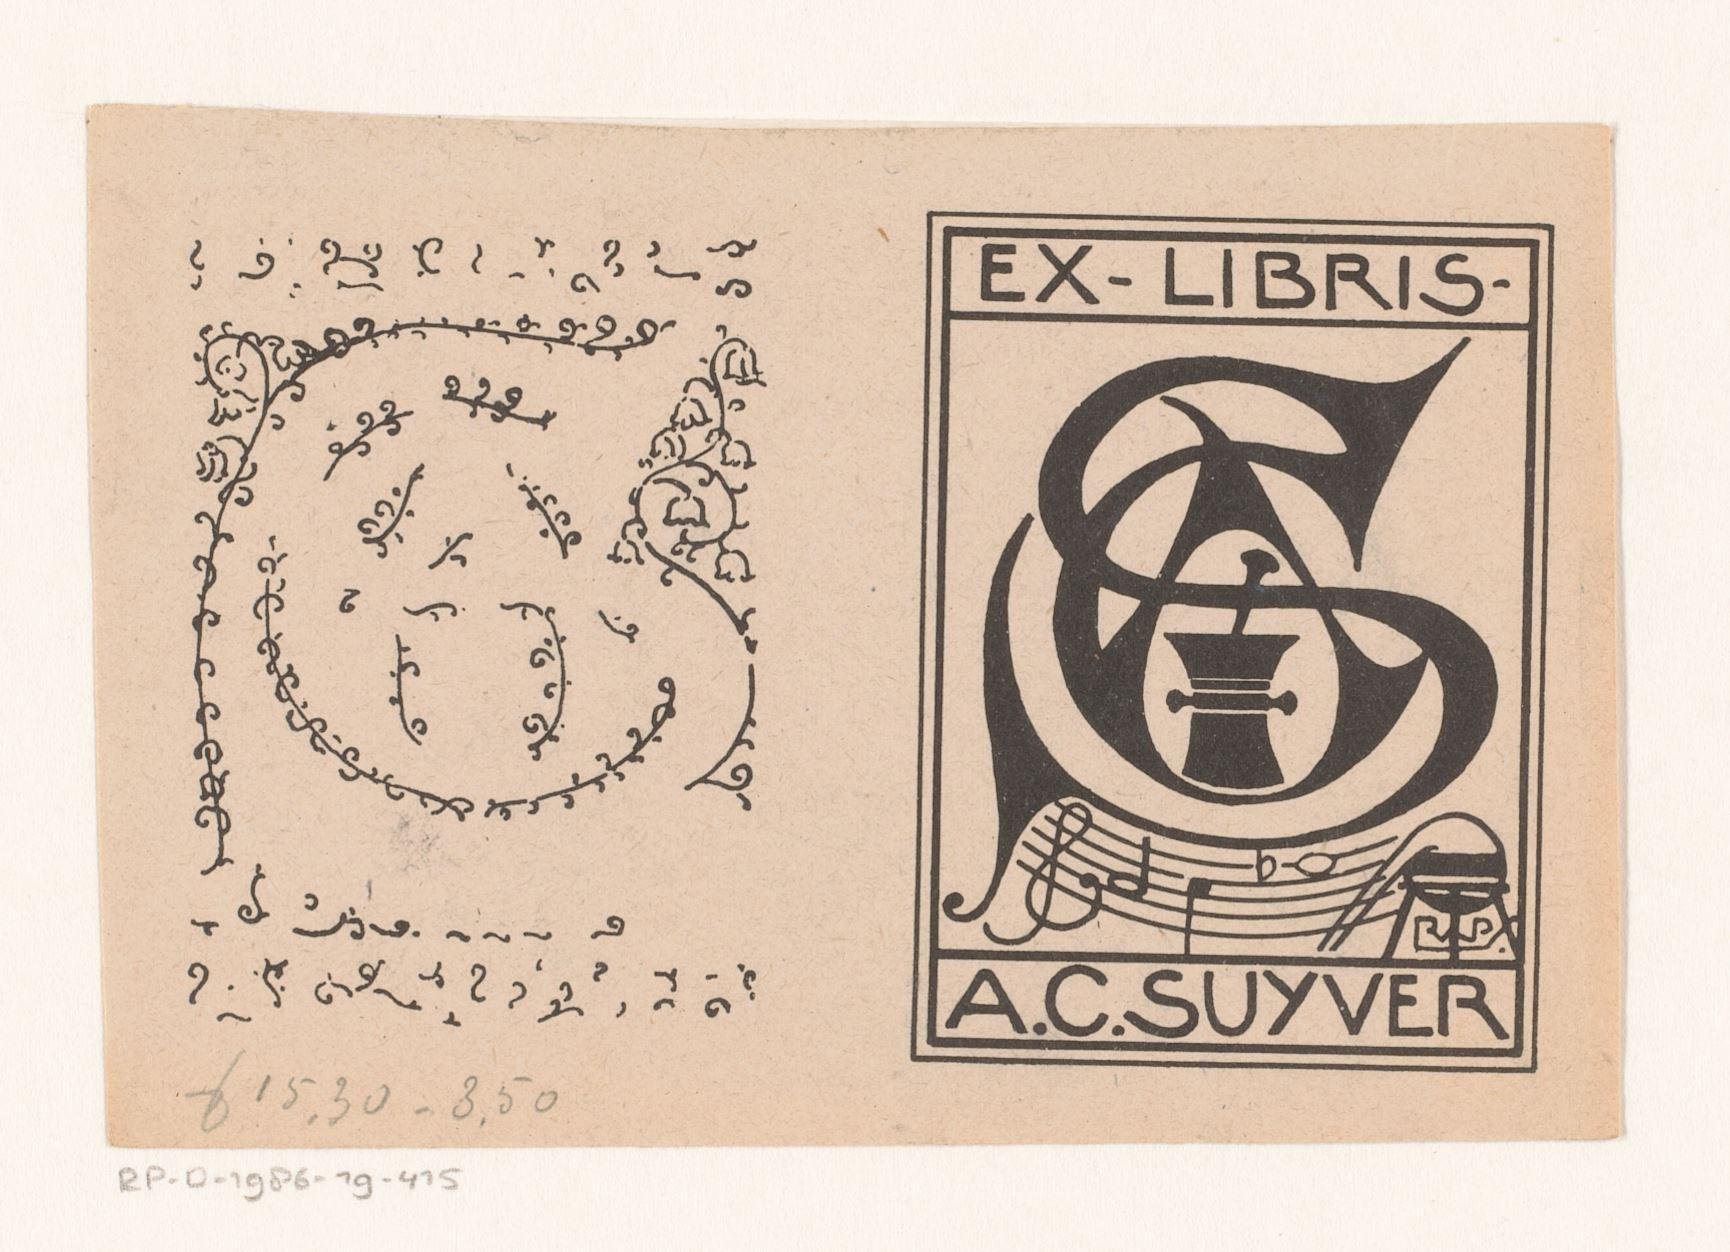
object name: design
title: Ontwerp voor een ex libris van A.C. Suyver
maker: reinier willem petrus de vries (1874-1953)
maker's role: draughtsman, print maker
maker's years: 1874-1953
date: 1884-1952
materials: paper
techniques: printing block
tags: notation of music, container of glass: bottle, jar, vase, container of ceramics: jar, jug, pot, vase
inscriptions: collector's mark: ‘R:MVS.’, annotation: ‘f 15,30 - 8,50’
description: Ontwerp met het monogram ACS, een apothekerspot, muzieknotatie en glazen kolf met vloeistof.